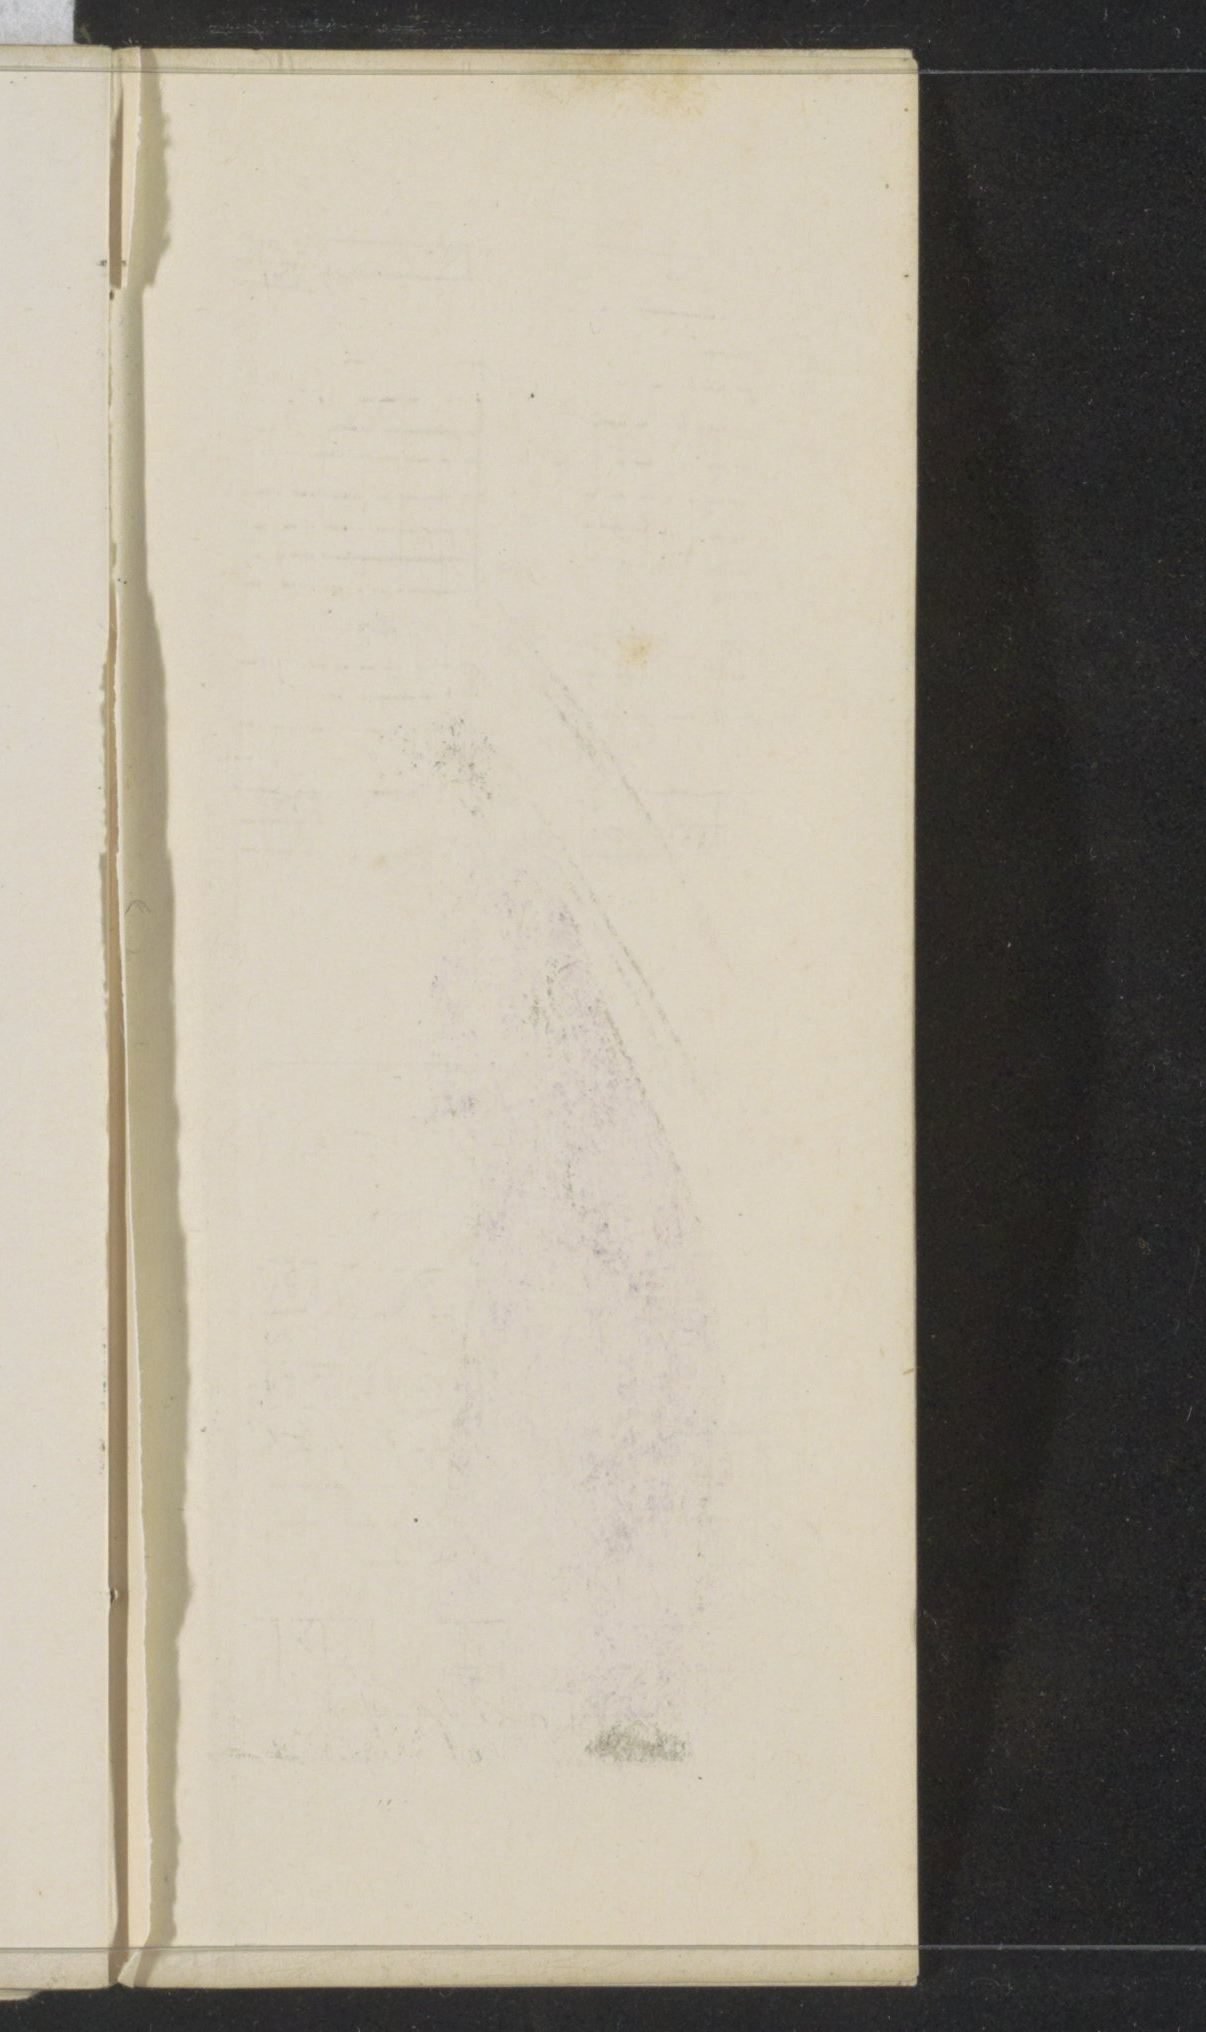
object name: sketchbook leaf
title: Abklatsch van een krijttekening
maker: gerrit willem dijsselhof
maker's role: designer, draughtsman, print maker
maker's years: 1866-1924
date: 1901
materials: paper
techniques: printmaking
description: Tekening van een staande vrouw in een lange jurk. De tekening is niet langer aanwezig in het schetsboek maar vertoont gelijkenissen met de tekening op blad 39 recto. Blad 42 recto uit een schetsboek met 42 bladzijden.